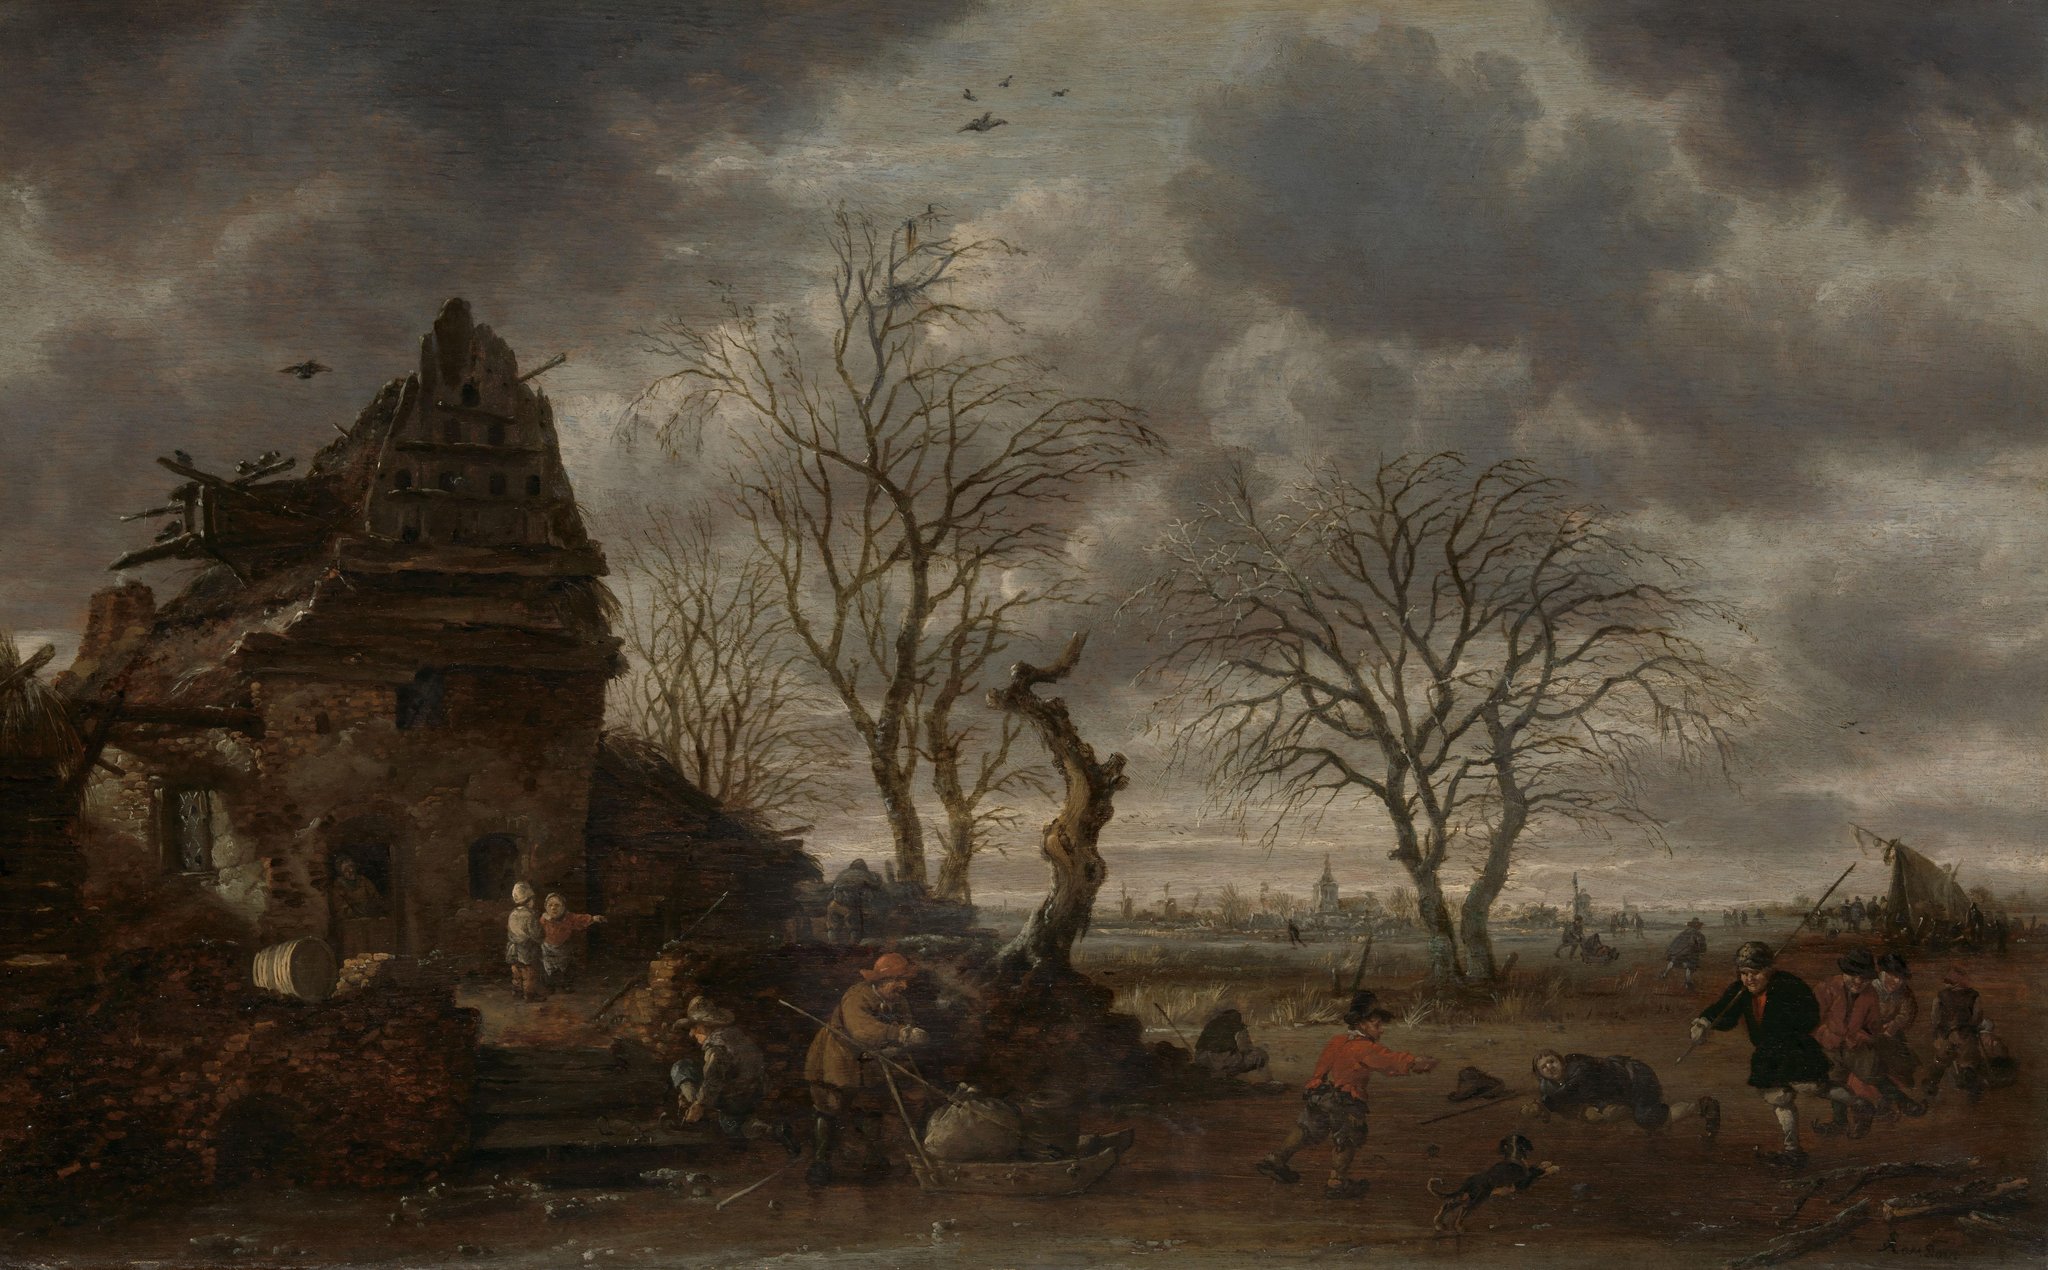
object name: painting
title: Winter scene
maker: salomon rombouts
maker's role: painter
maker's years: 1652-1702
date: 1660-1702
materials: oil, panel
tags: ice ~ freezing weather, winter landscape; landscape symbolizing winter (the four seasons of the year), skates (winter sports)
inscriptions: signature: ‘S. Rombout’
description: Wintergezicht. Winterlandschap met rechts schaatsers op het ijs en links een oude vervallen boerenwoning met duiventil. In de verte een tent en het profiel van een dorpje.